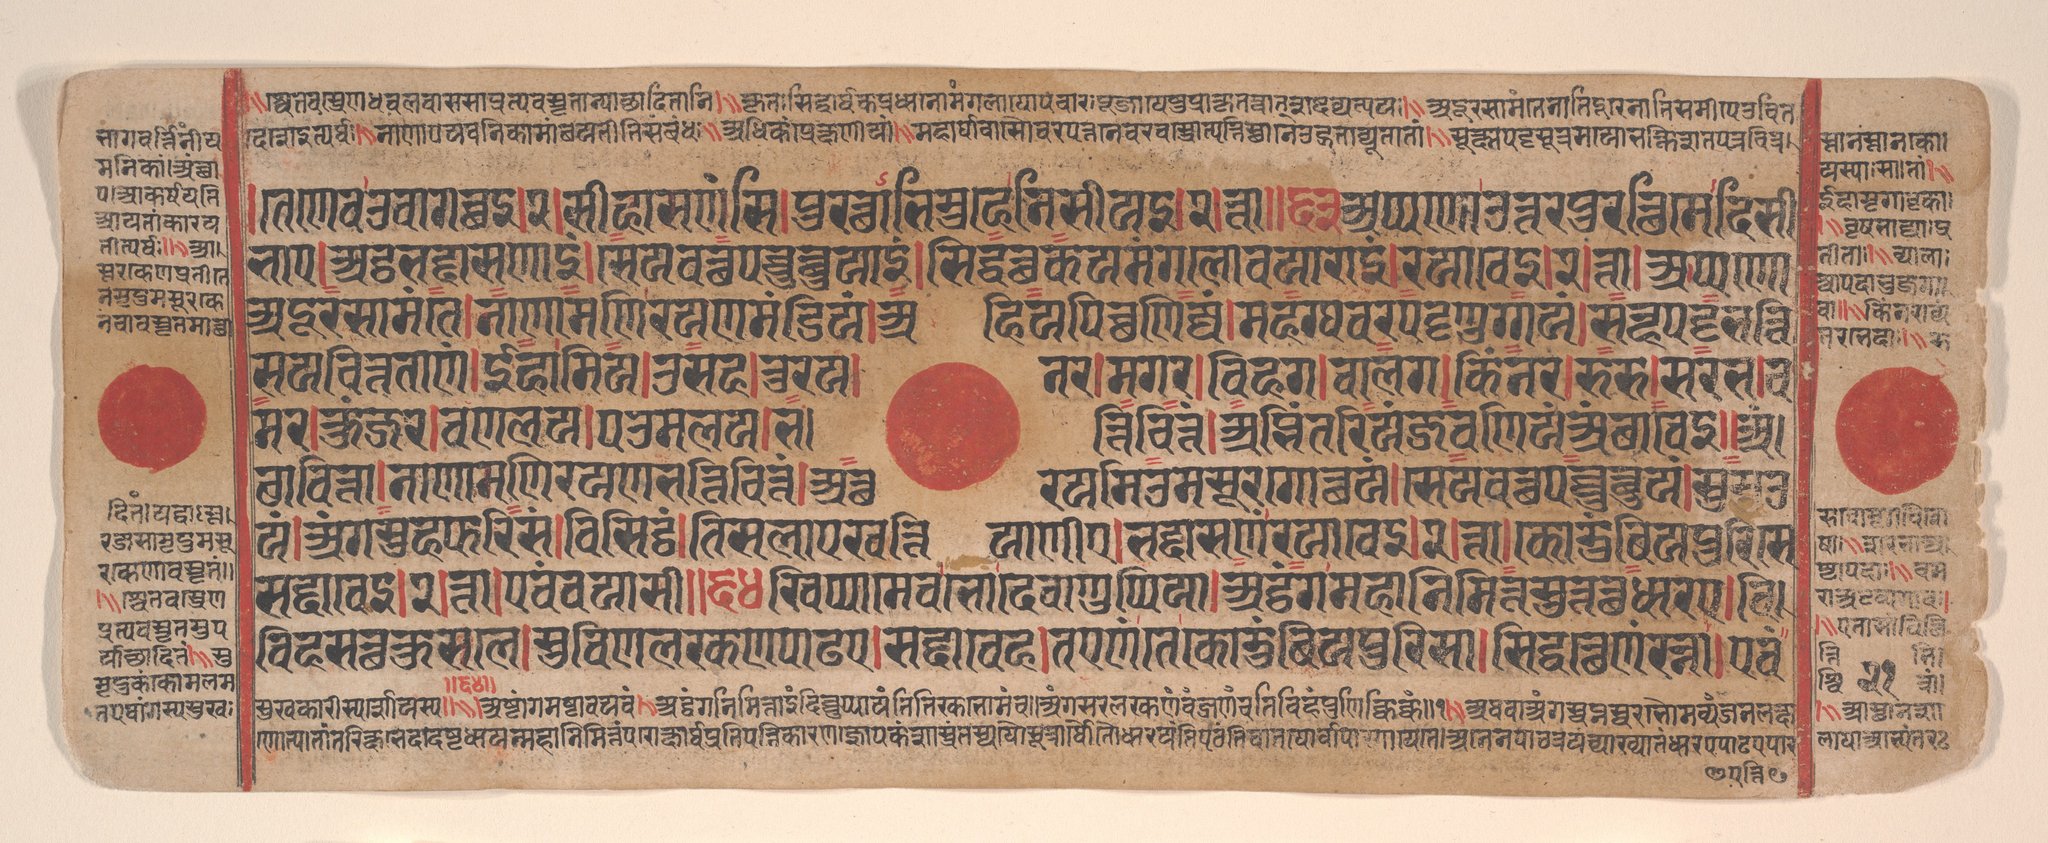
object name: folio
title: Leaf from a Kalpa Sutra (Jain Book of Rituals)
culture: indian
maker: bhadrabahu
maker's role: artist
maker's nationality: indian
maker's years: 356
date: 1401-1500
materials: gold, ink, paper, watercolor